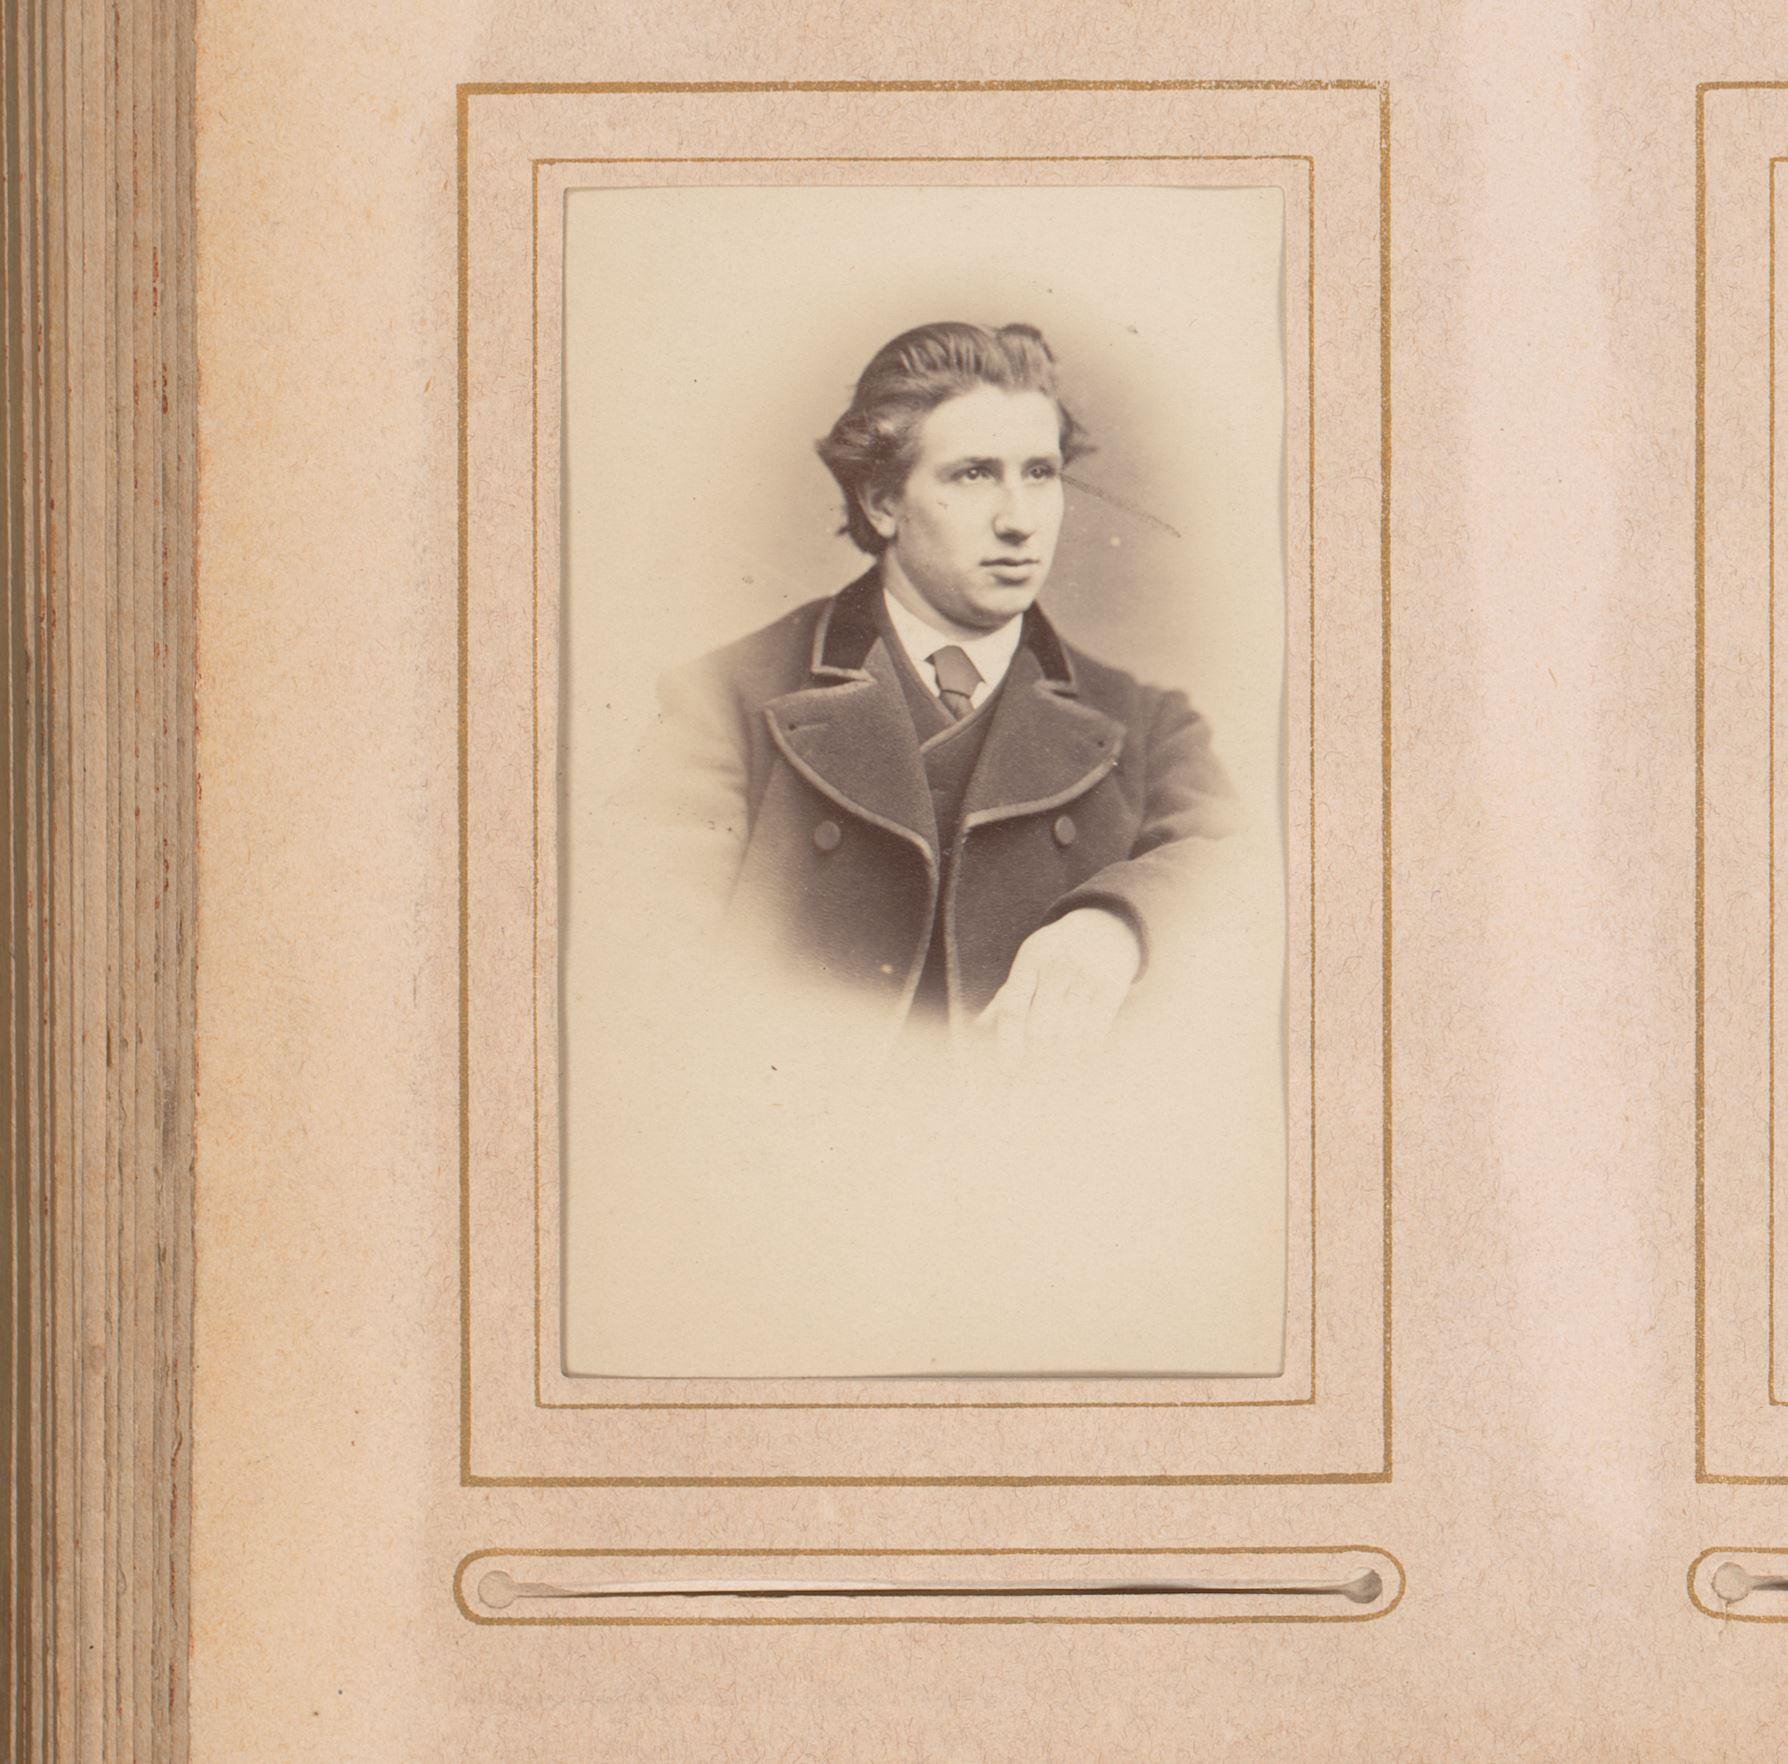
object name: album leaf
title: Portret van een man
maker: albert greiner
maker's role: fotograaf, fotostudio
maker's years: 1833-1890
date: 1861-1874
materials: cardboard, photographic support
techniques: albumen print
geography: amsterdam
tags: historical persons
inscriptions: inscription: ‘A. Greiner/ Photograf/ Nieuwendijk L.87/ Amsterdam’